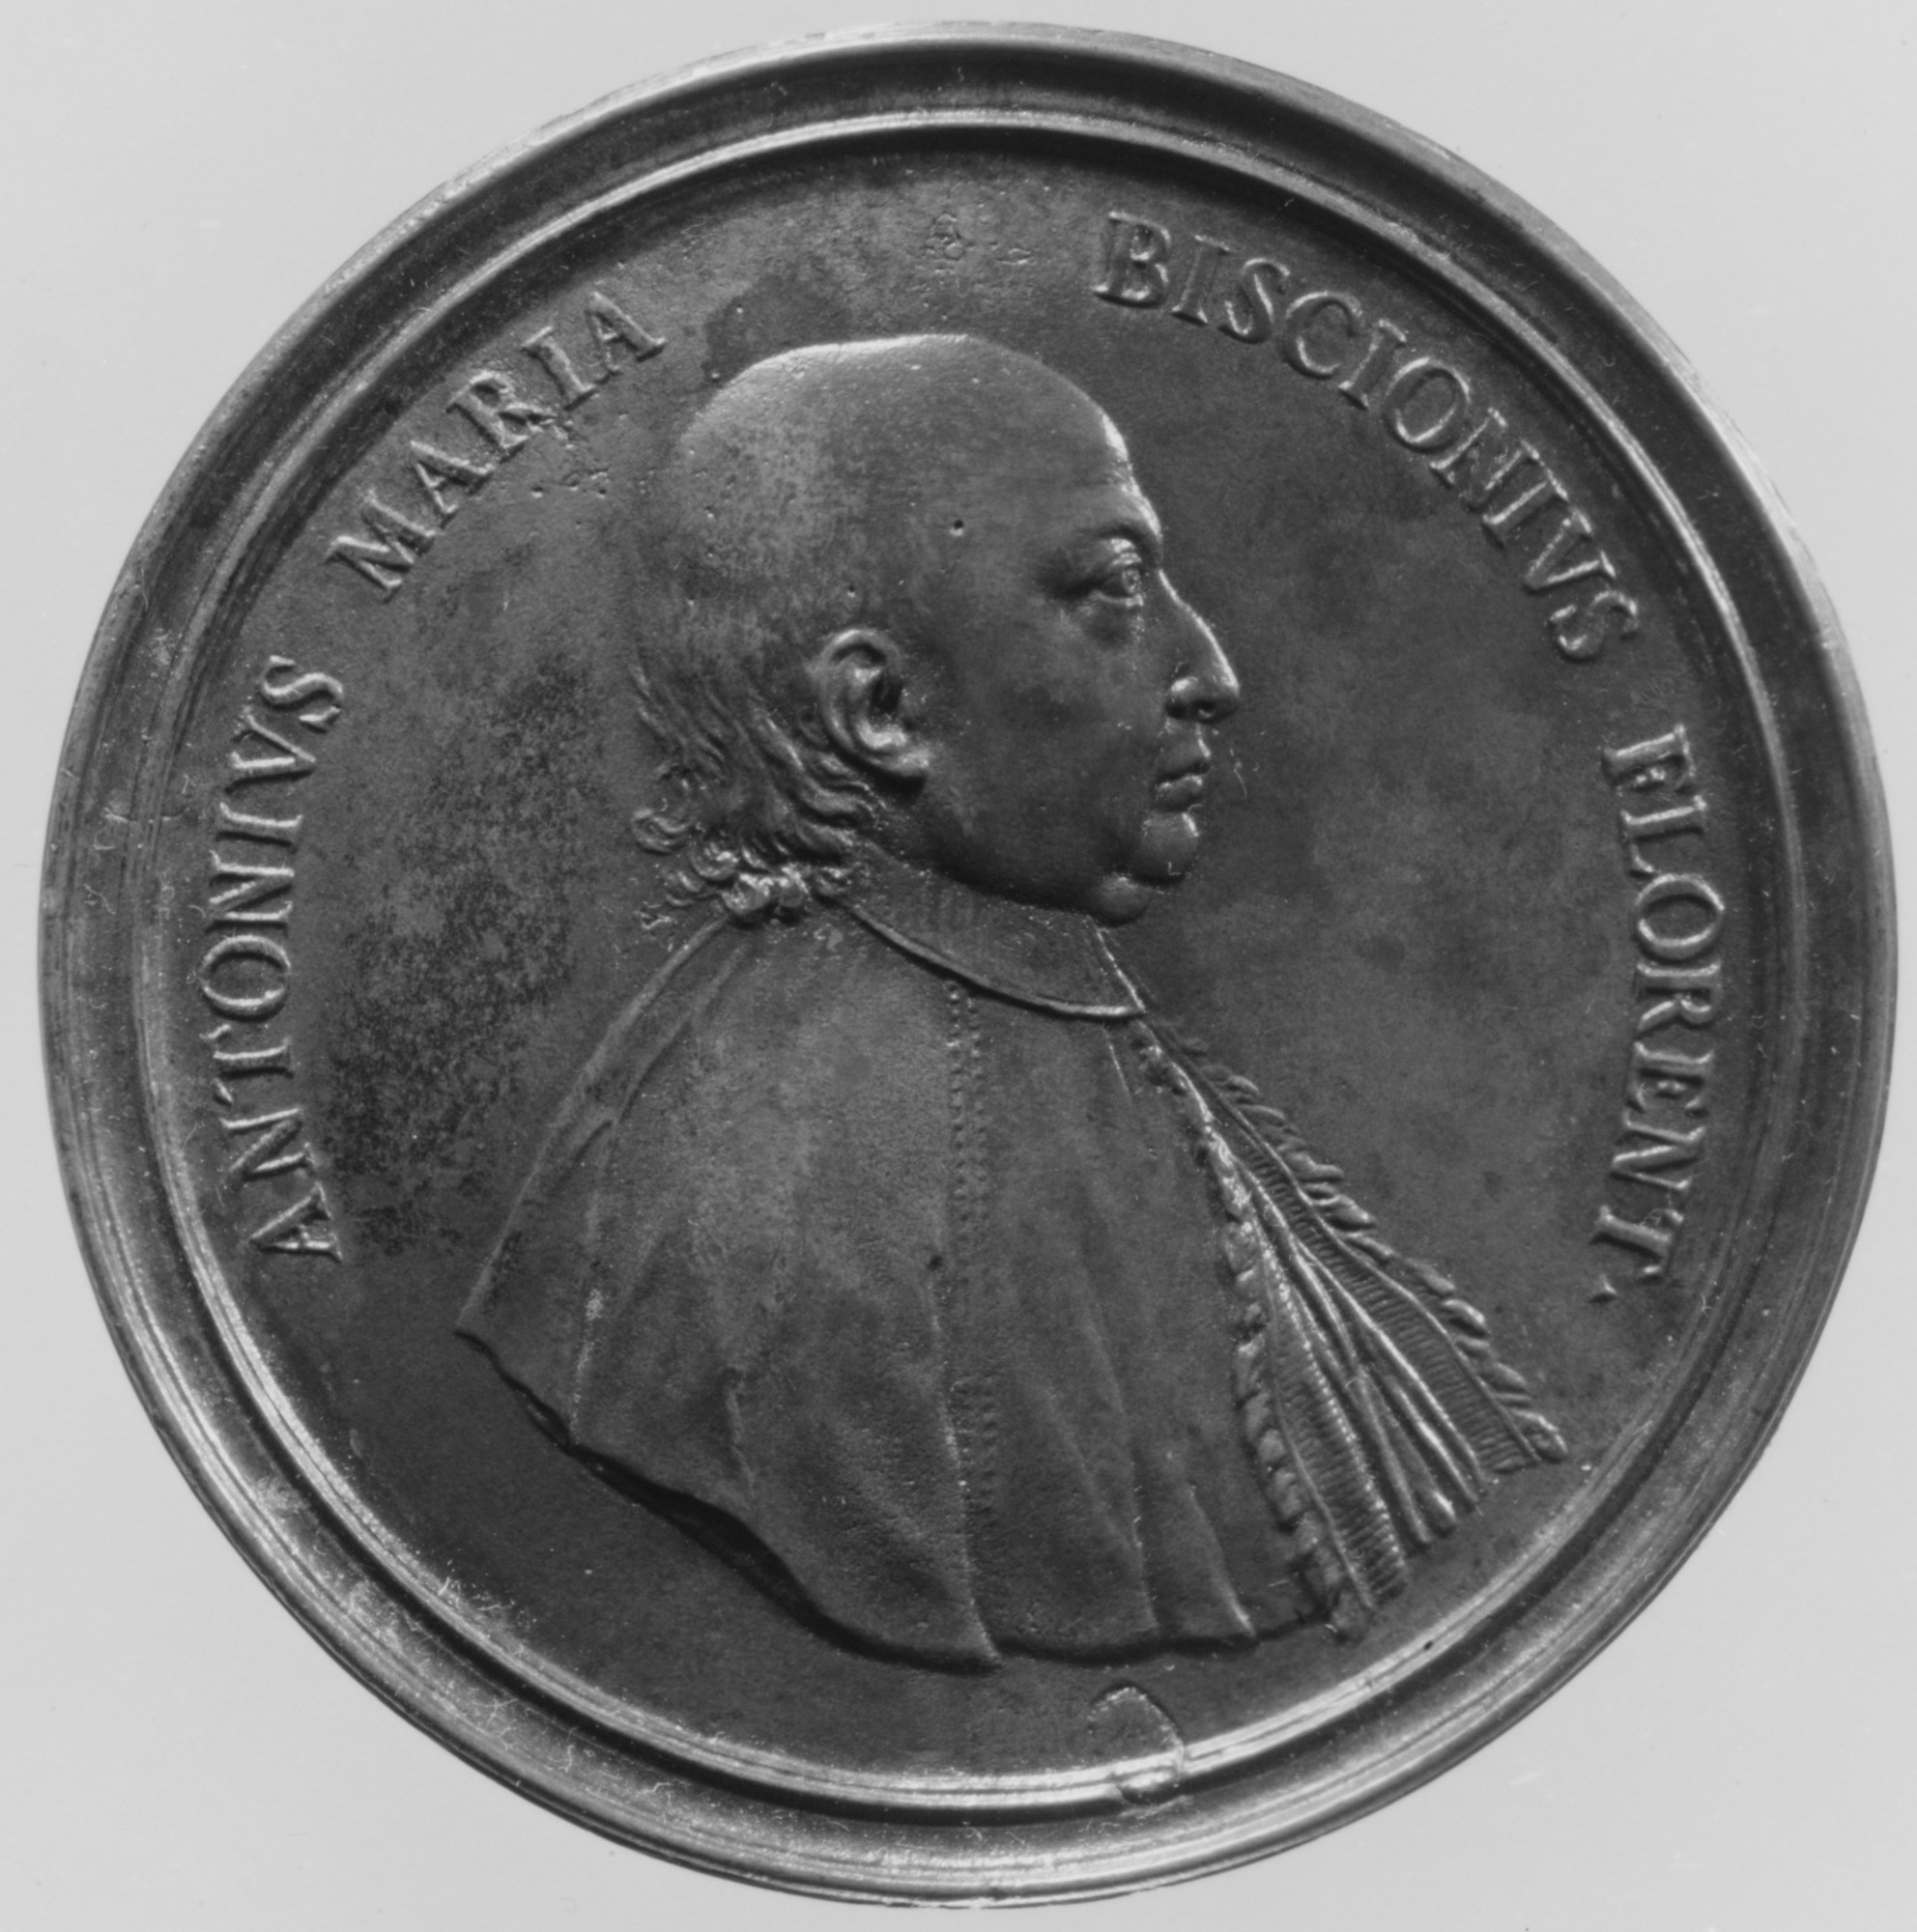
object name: medal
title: Antonio Maria Biscioni (1674–1756)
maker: lorenzo maria weber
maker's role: artist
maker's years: 1692-1764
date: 1725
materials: bronze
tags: men,profiles